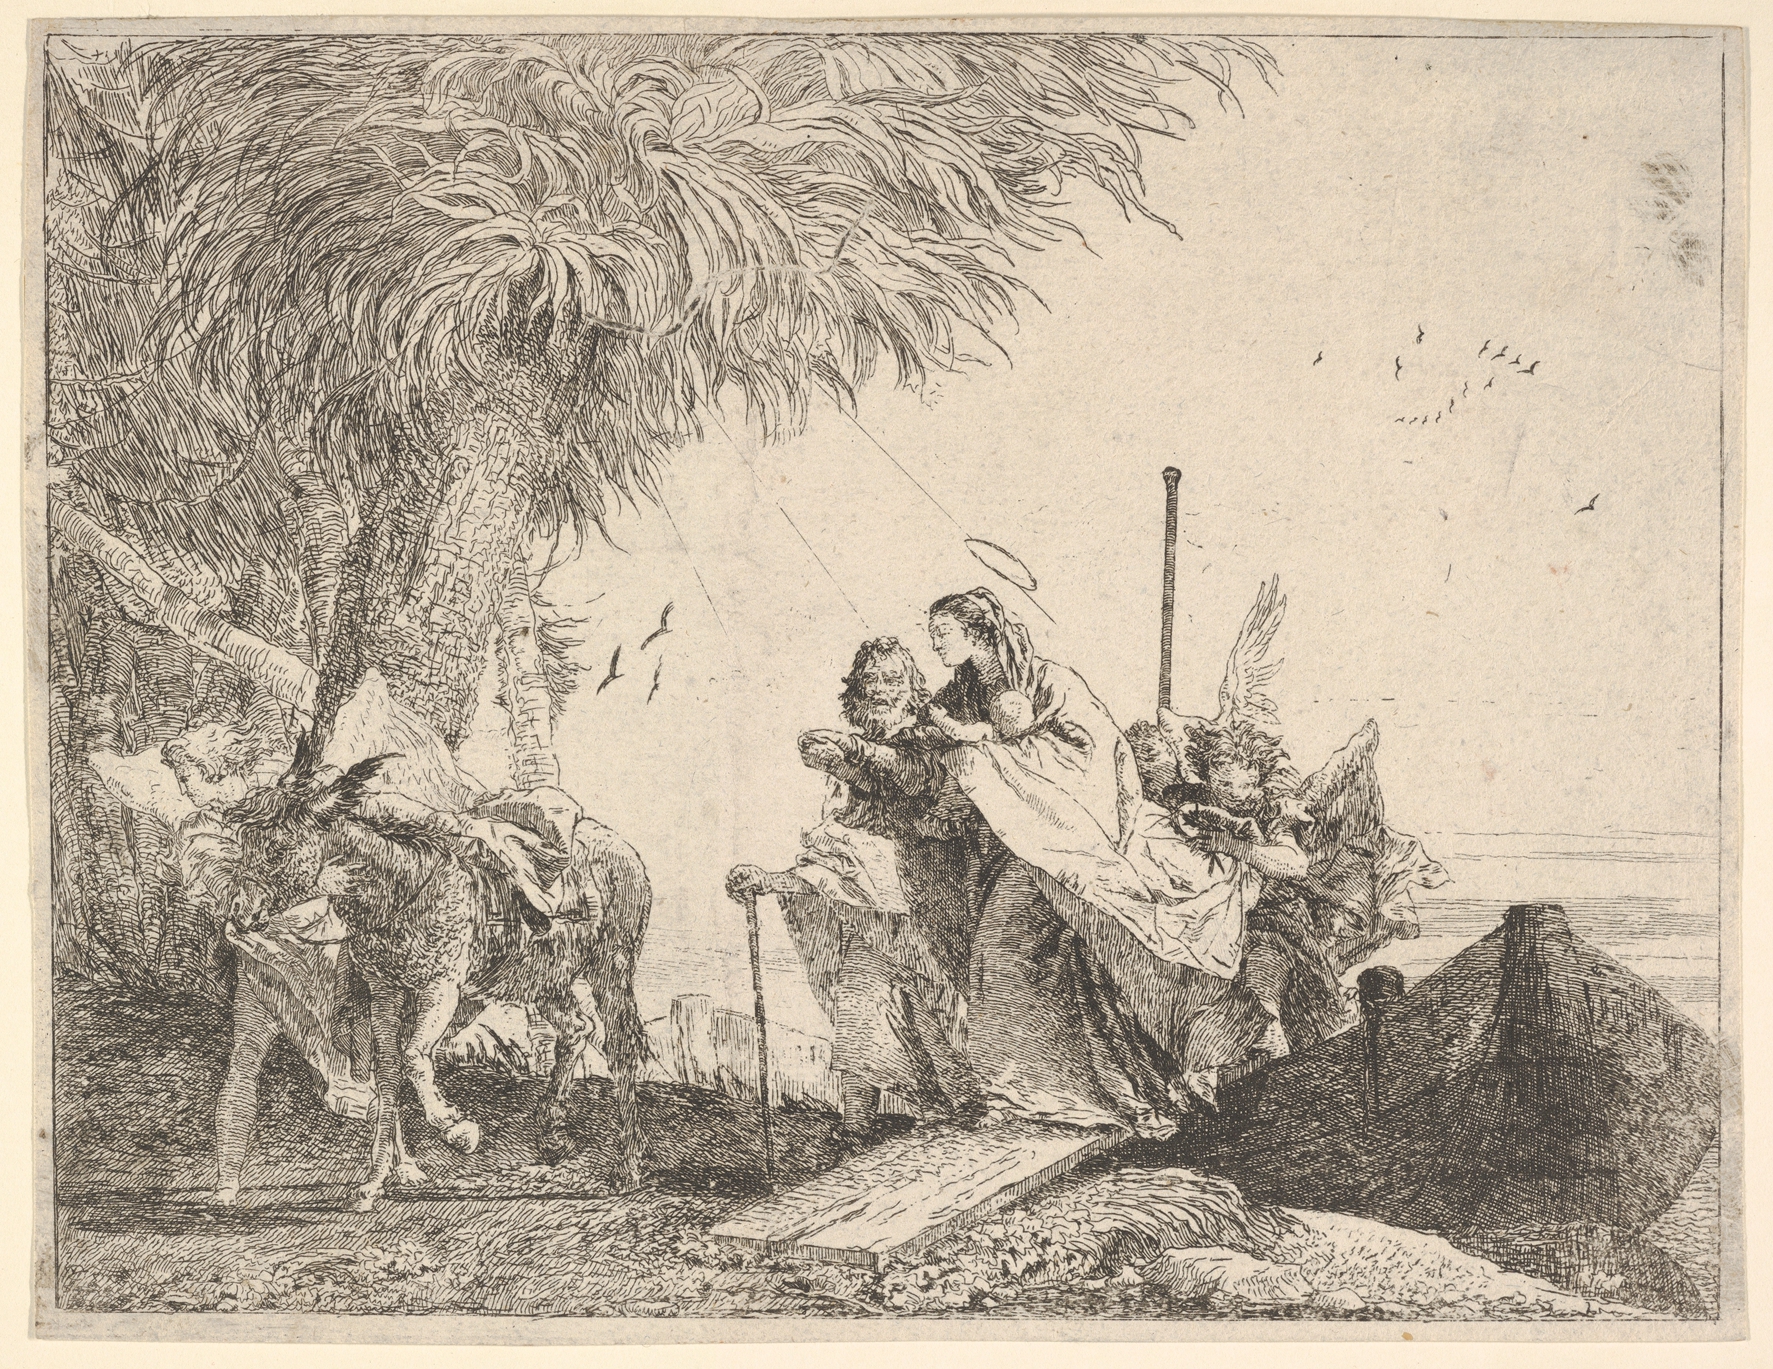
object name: print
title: Mary, helped by Joseph and an angel, stepping from a boat to the shore, an angel steadies a donkey before her, from "The Flight into Egypt"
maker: giovanni domenico tiepolo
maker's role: artist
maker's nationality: italian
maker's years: 1727-1804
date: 1753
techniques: etching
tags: donkeys,angels,christ,saint joseph,virgin mary,boats